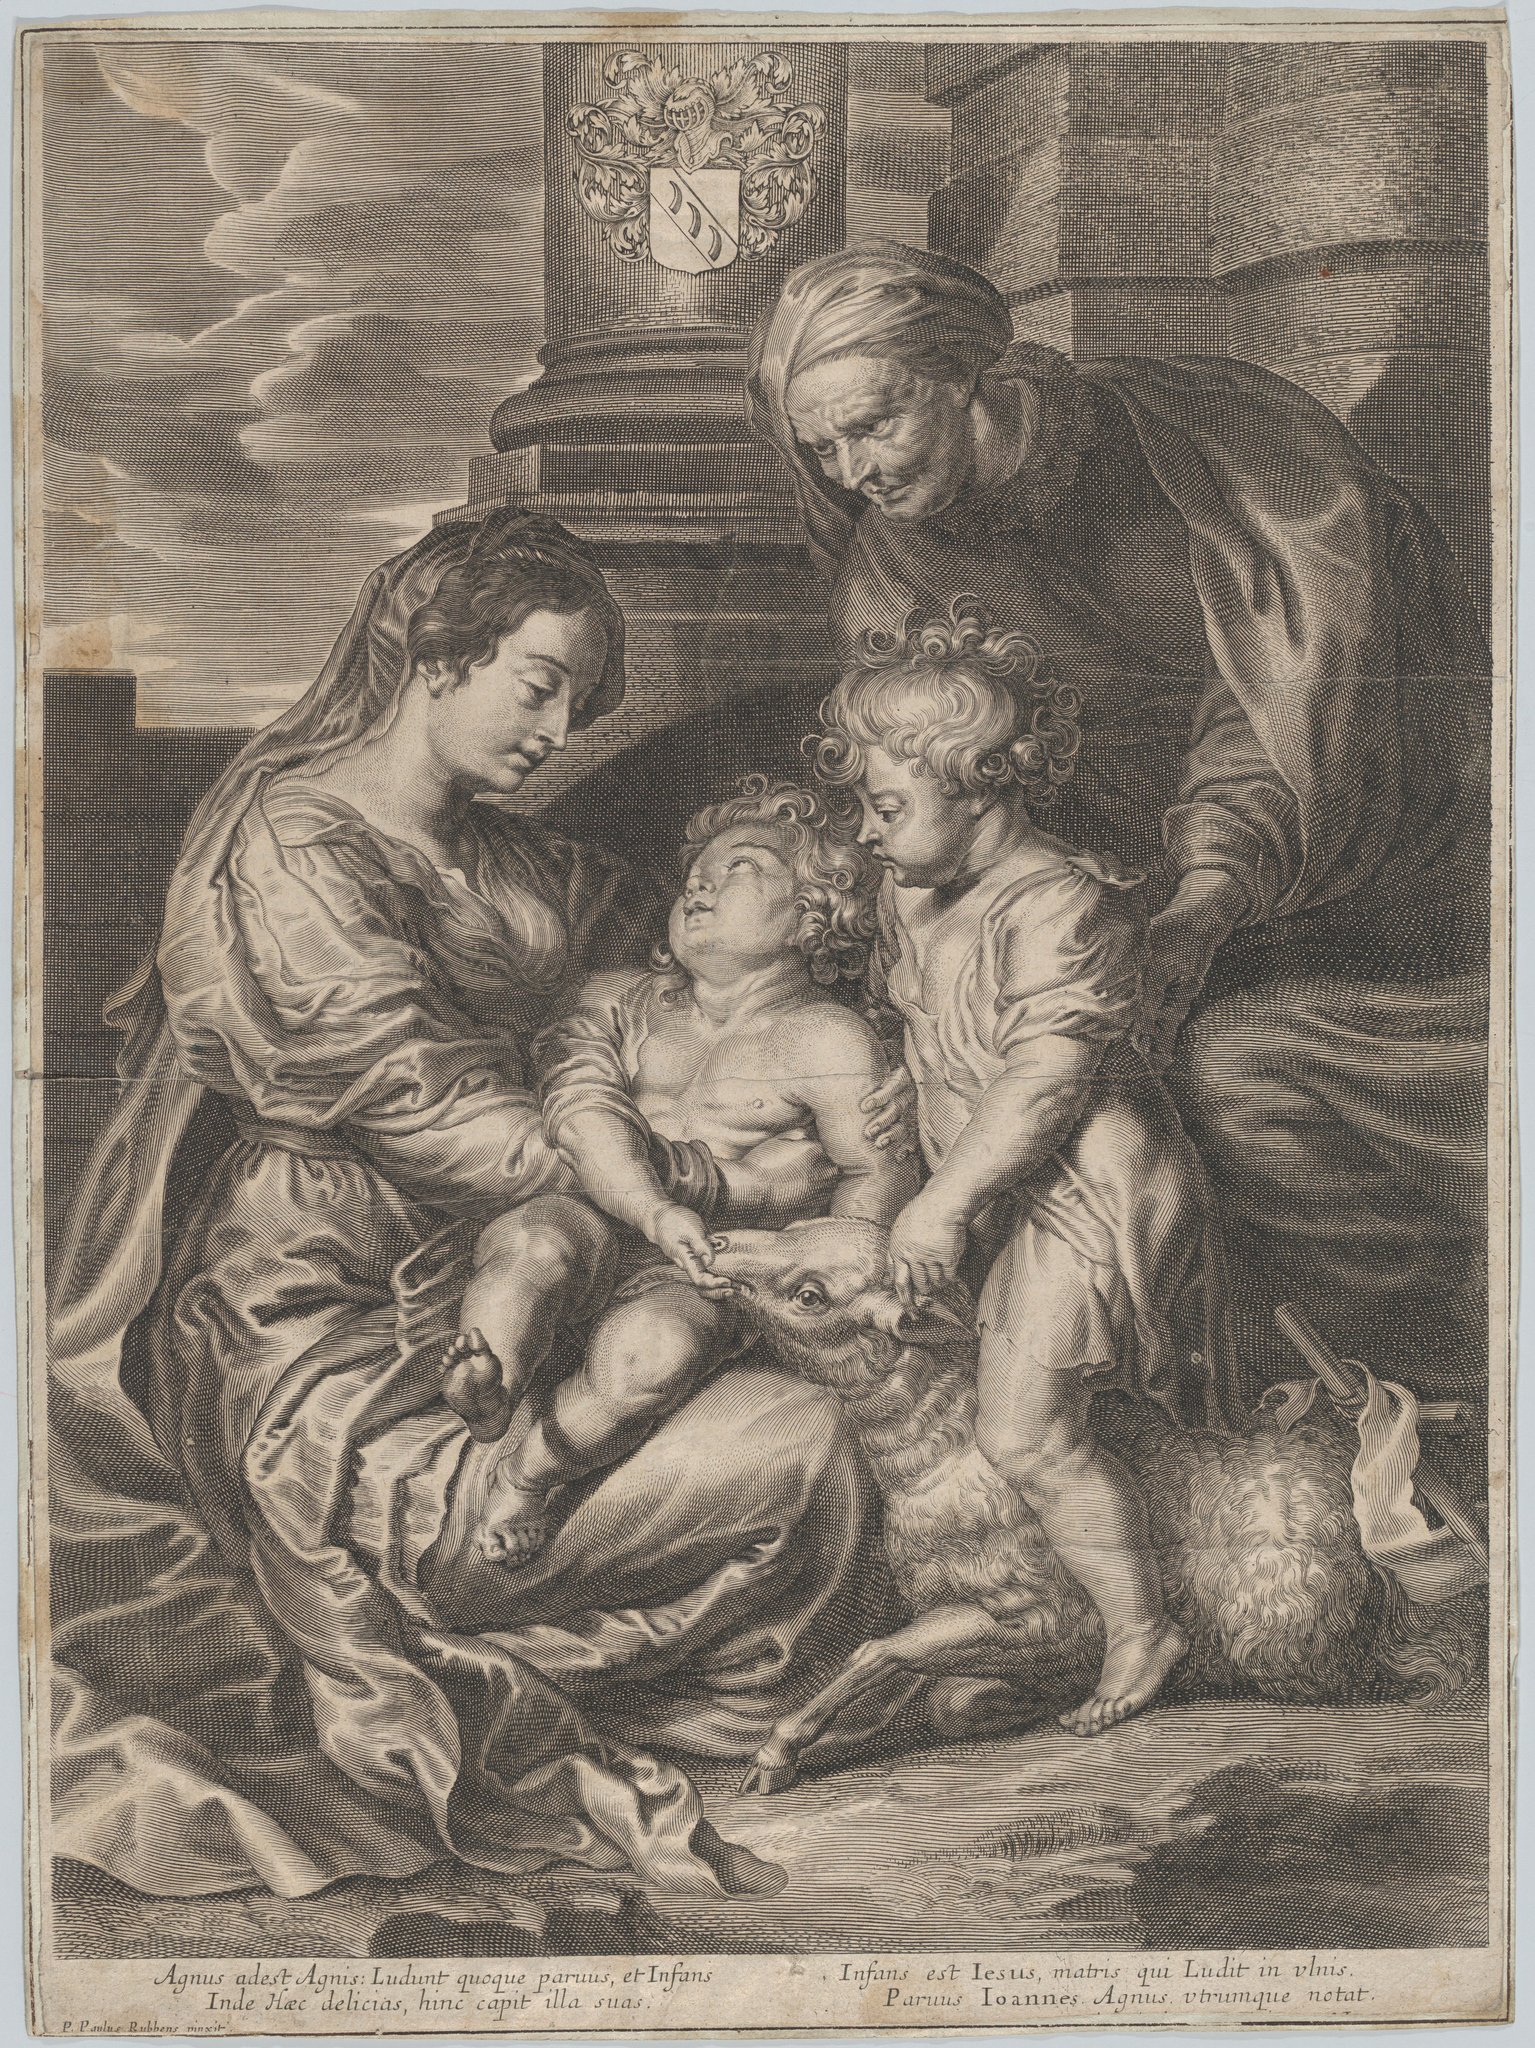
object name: print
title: The Virgin and Child with Saint Elizabeth and Saint John the Baptist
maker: Anonymous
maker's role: artist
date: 1650-1700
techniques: engraving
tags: saint john the baptist,virgin mary,jesus,saints